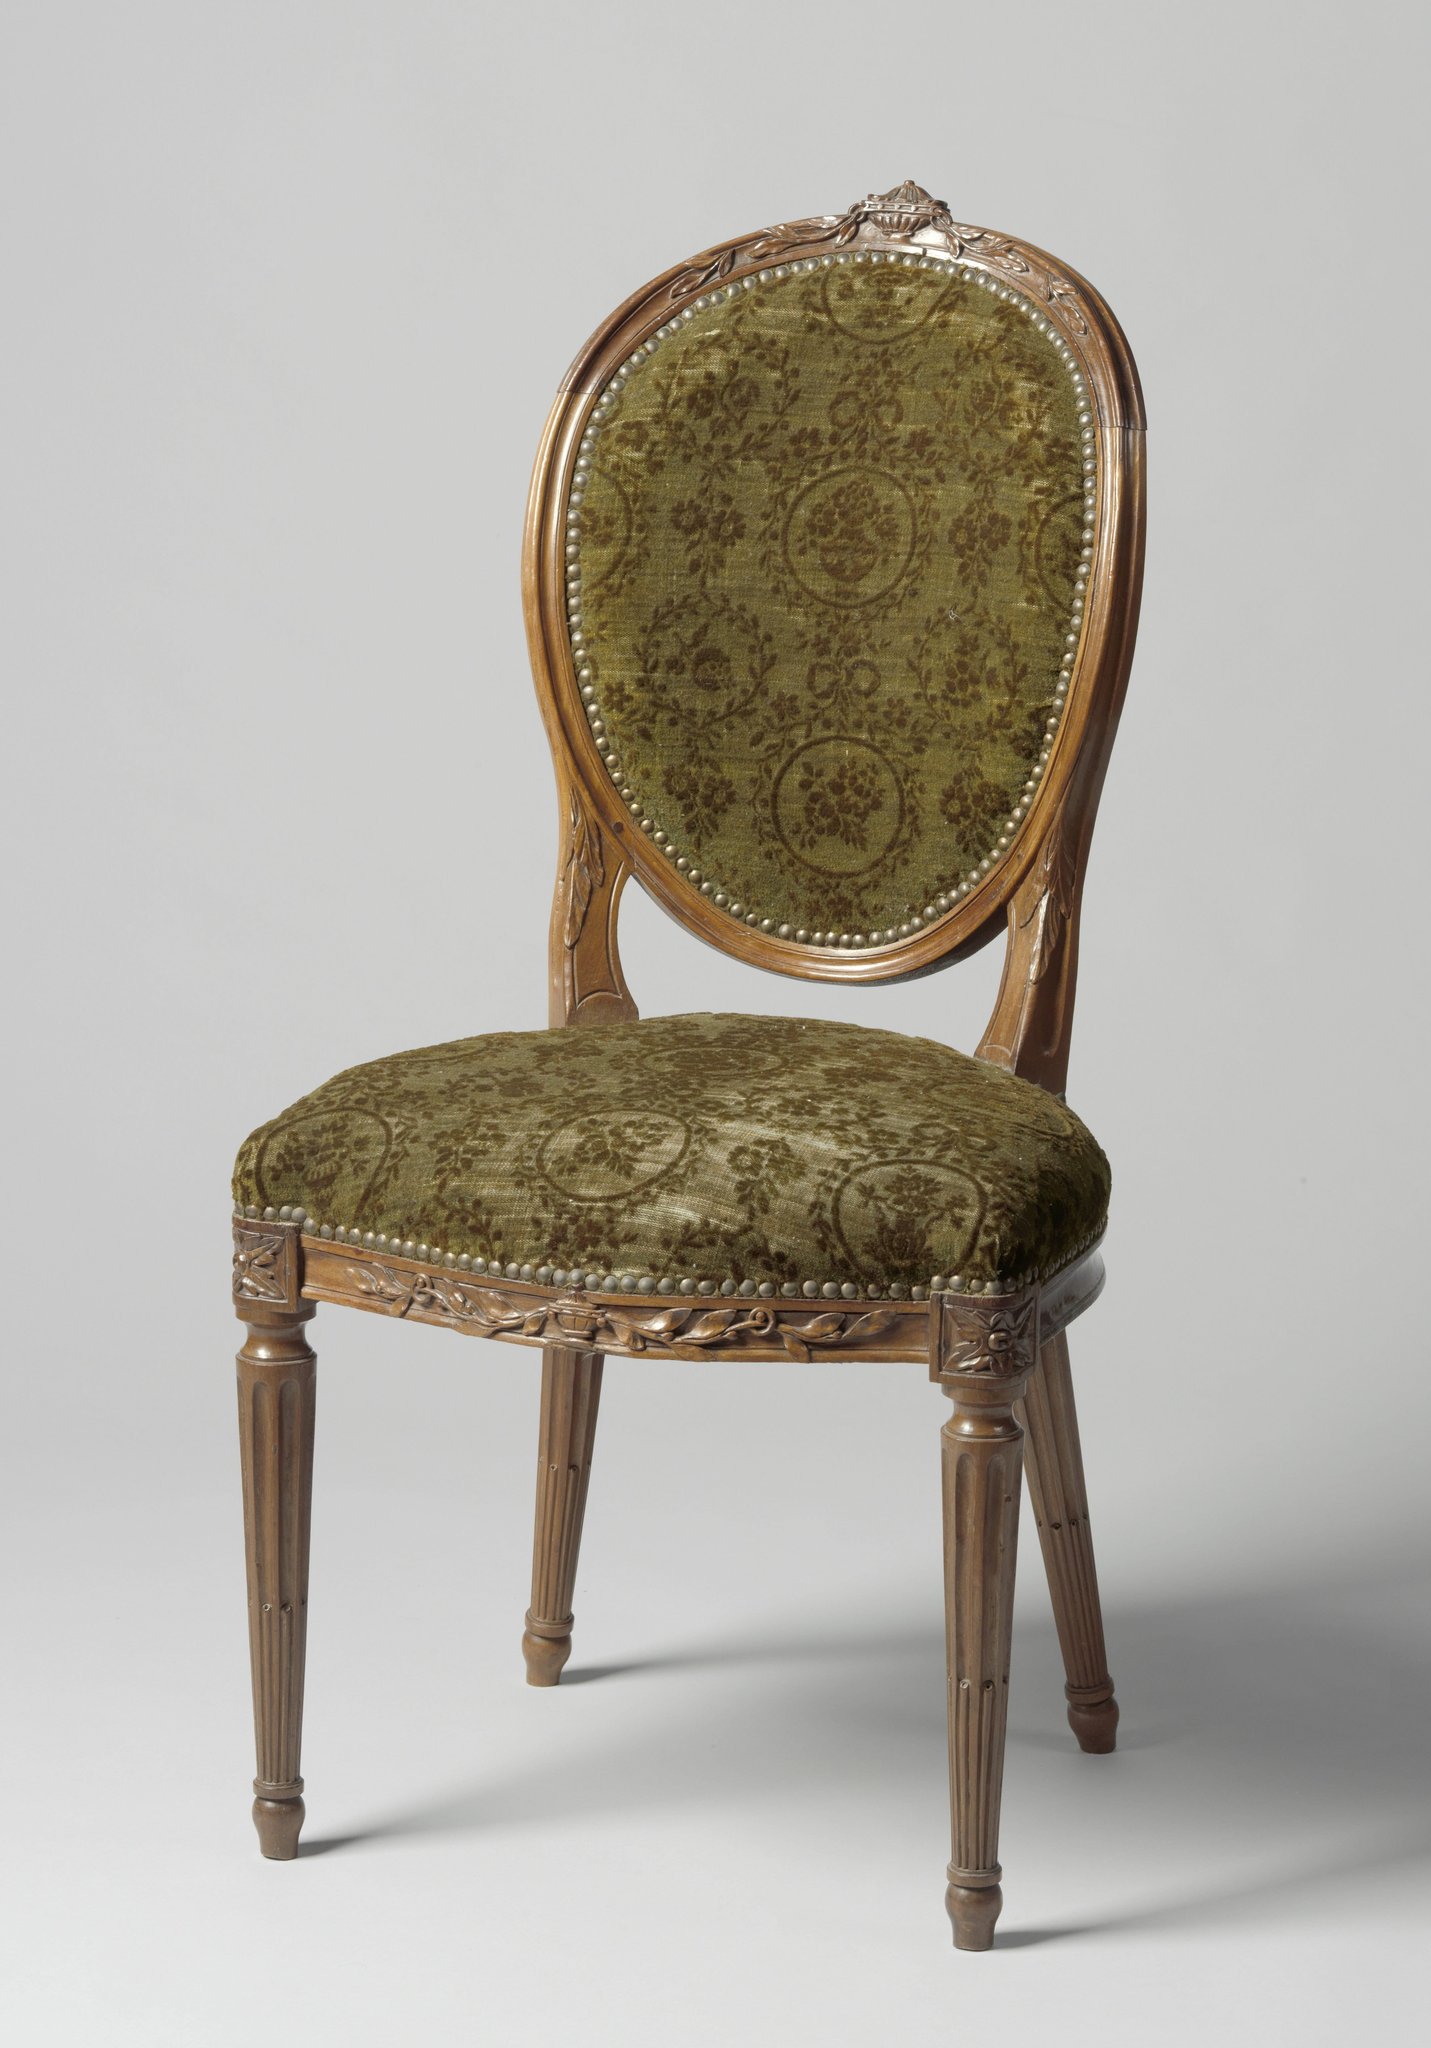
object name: chair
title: Stoel van mahoniehout, bekleed met groene trijp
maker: Anonymous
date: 1775-1800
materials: wood, textile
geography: northern netherlands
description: Armchair. Mahogany, the velvet upholstery has been renewed. Netherlands, c. 1780 - 1800. Given by Mr and Mrs Drucker-Fraser, 1922.